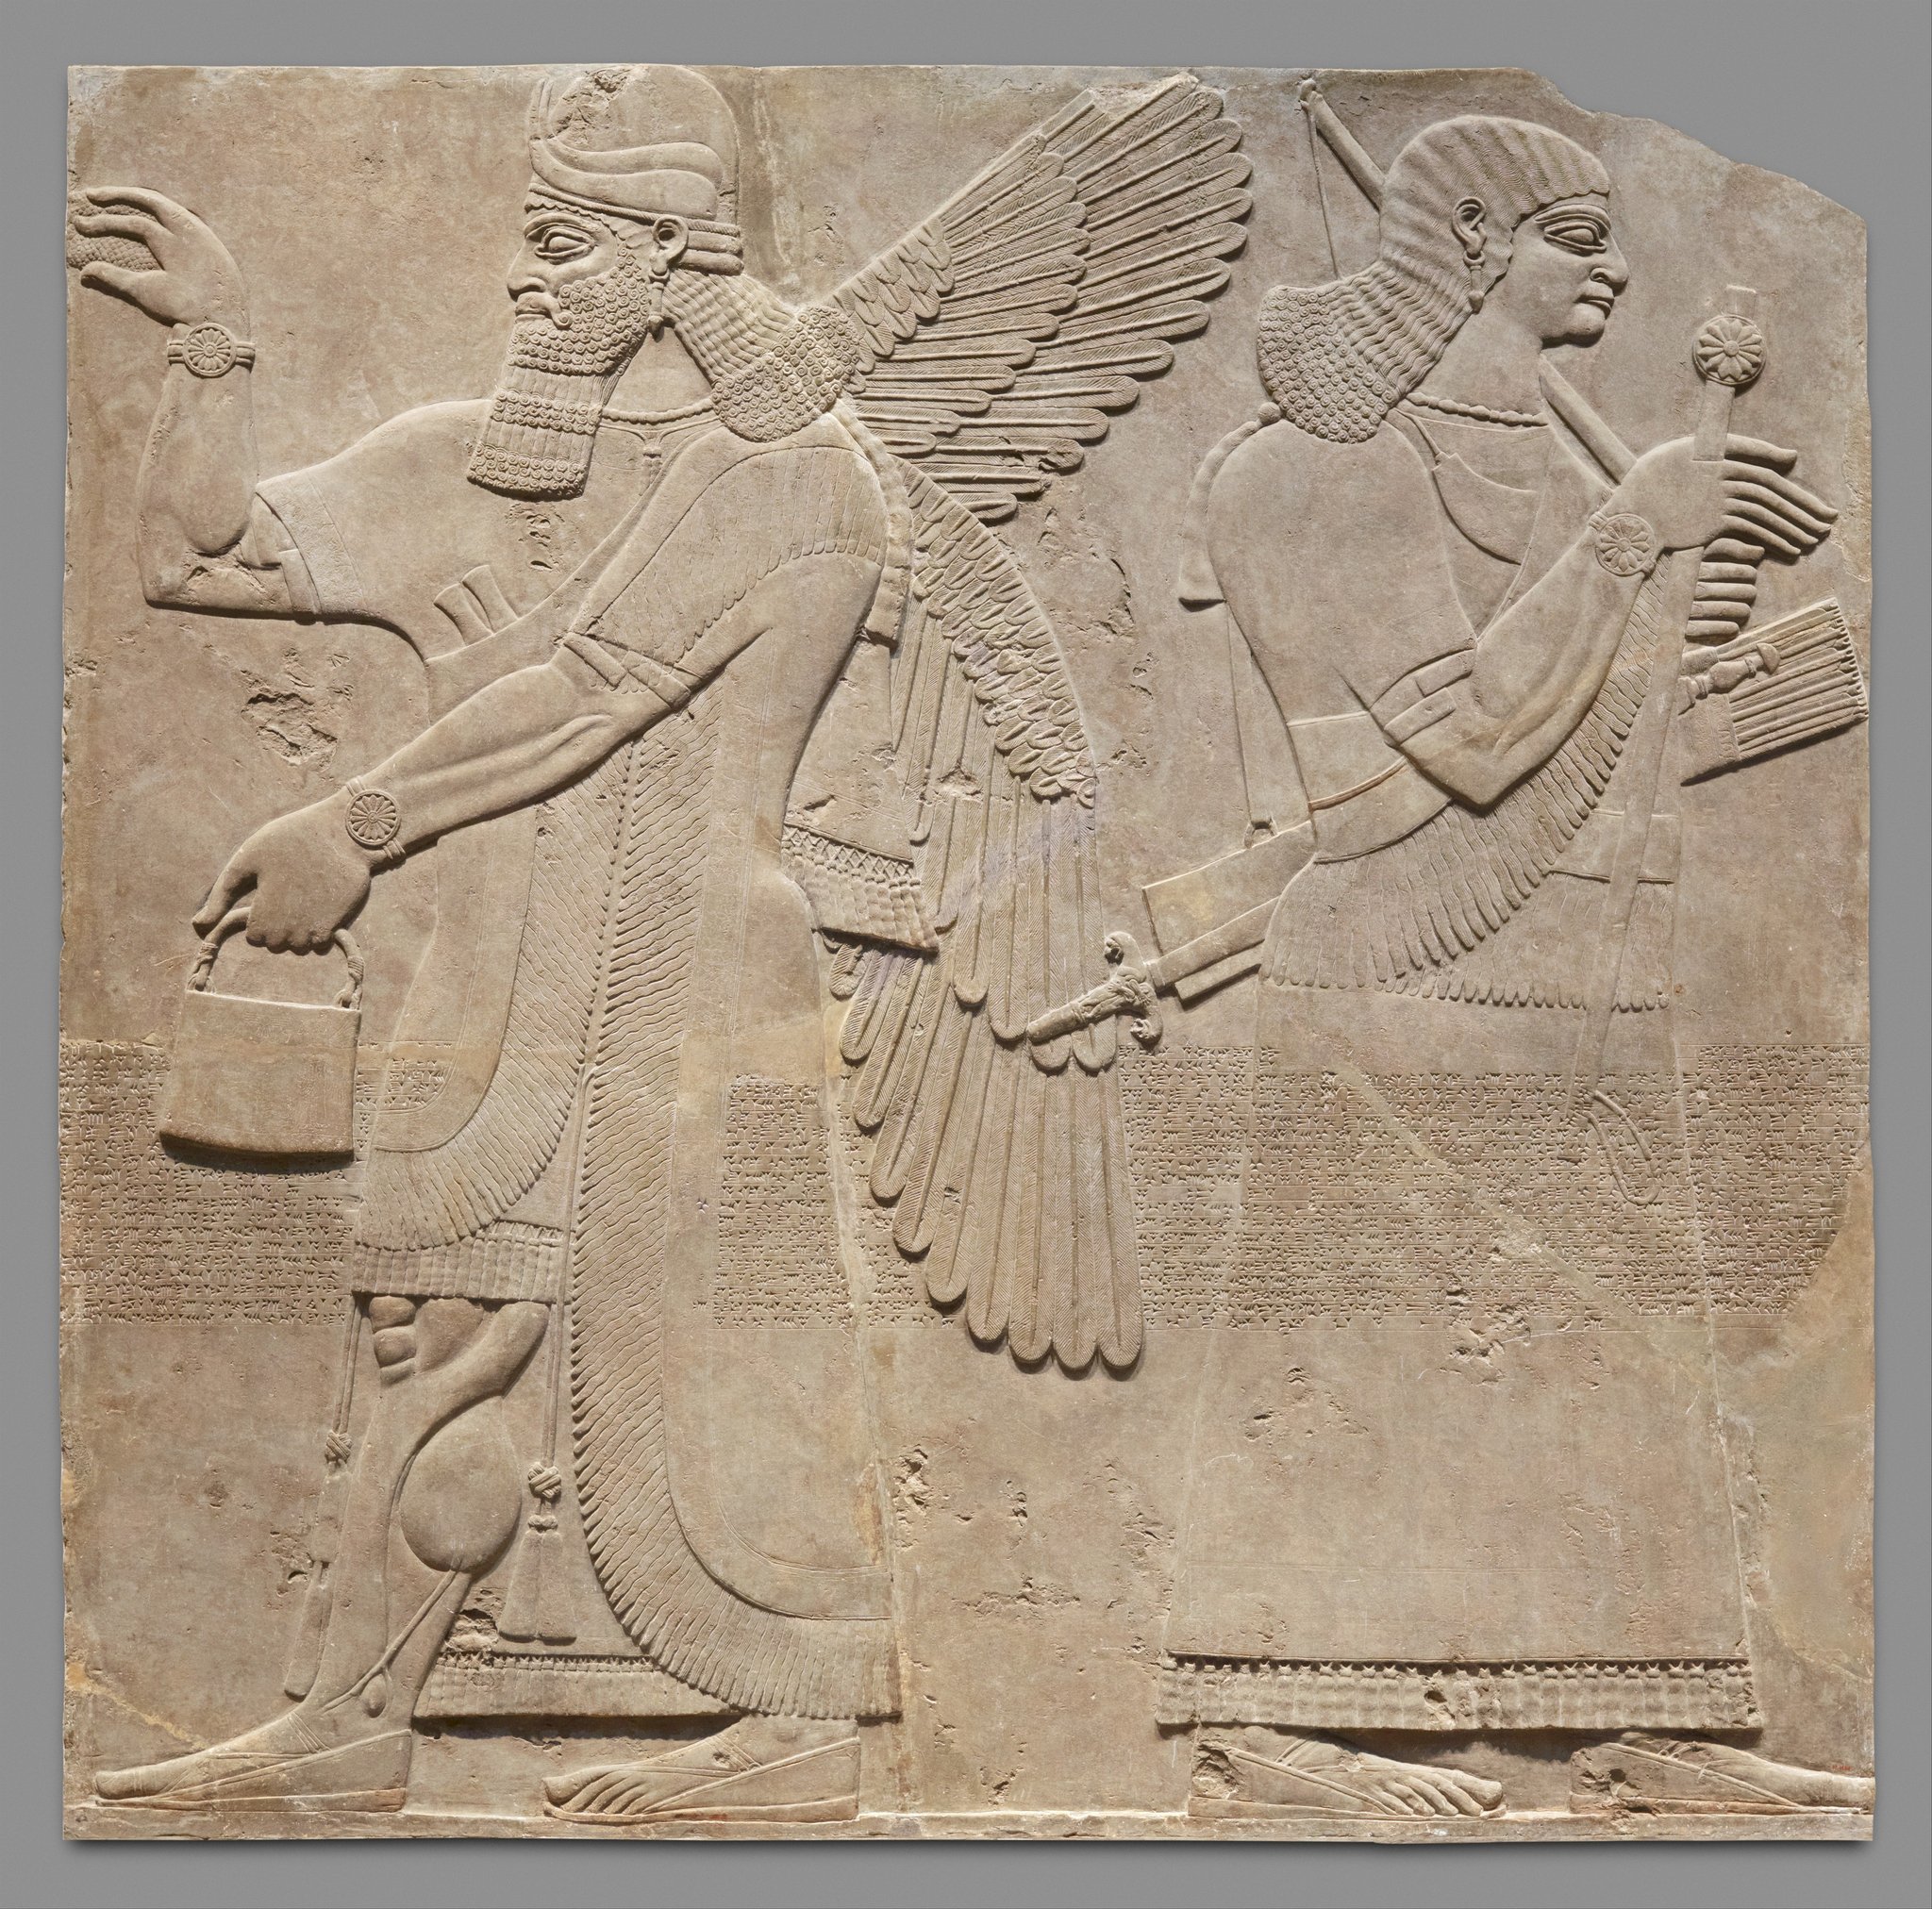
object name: relief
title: Relief panel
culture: assyrian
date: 883-859 BCE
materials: alabaster, gypsum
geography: mesopotamia